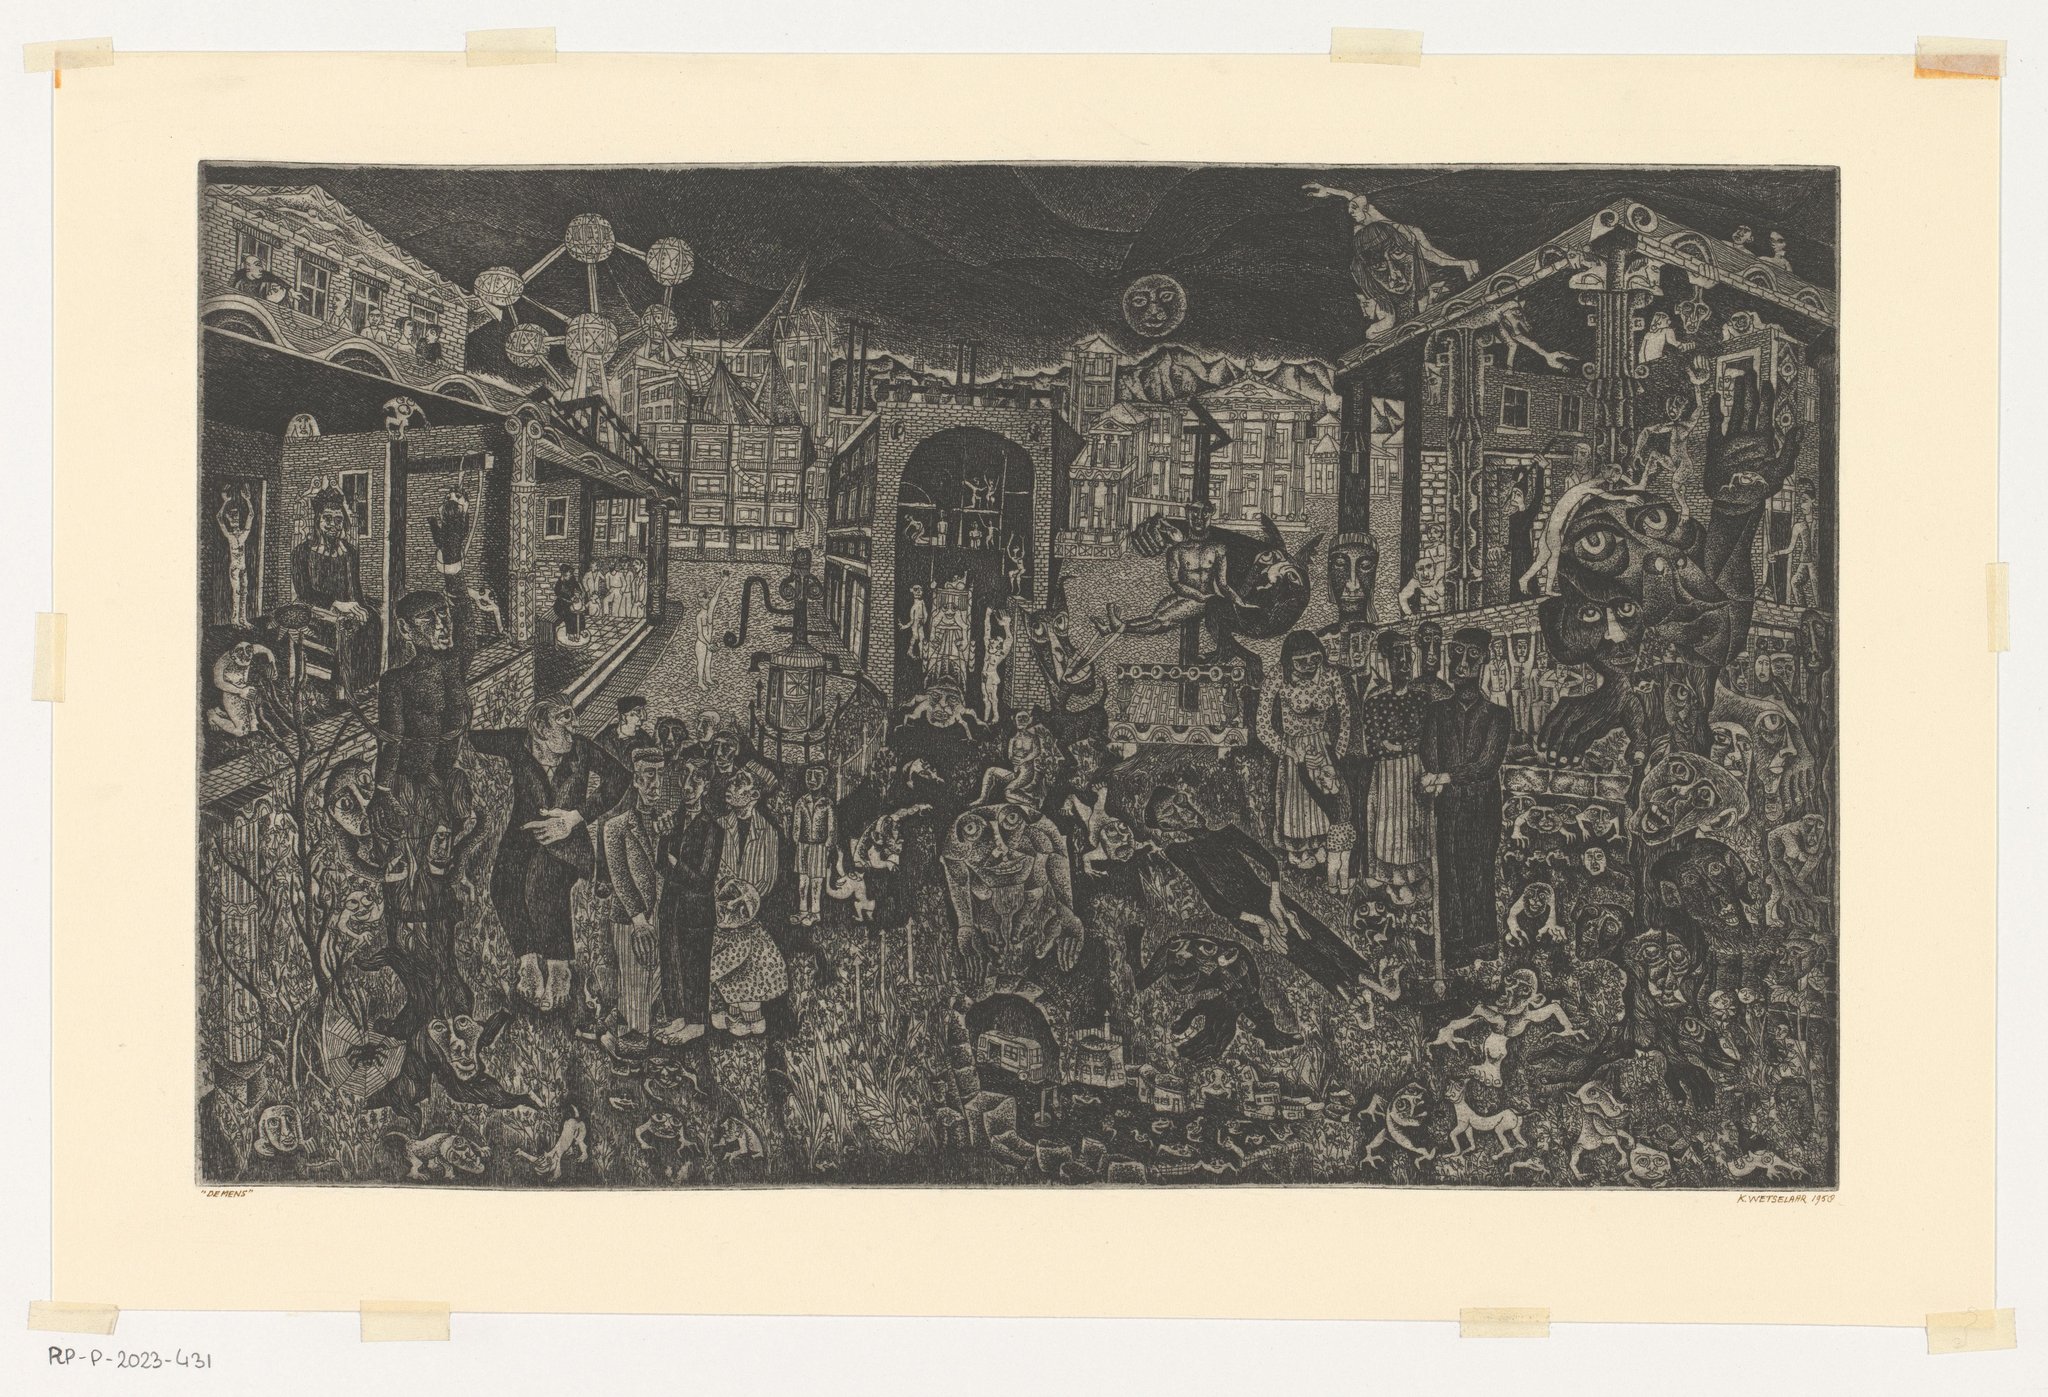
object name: print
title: De Mens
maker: karel wetselaar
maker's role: print maker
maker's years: 1935-2017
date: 1958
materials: paper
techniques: etching, intaglio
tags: city-view, and landscape with man-made constructions, monument, statue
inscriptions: signature and date: ‘K. Wetselaar 1958’